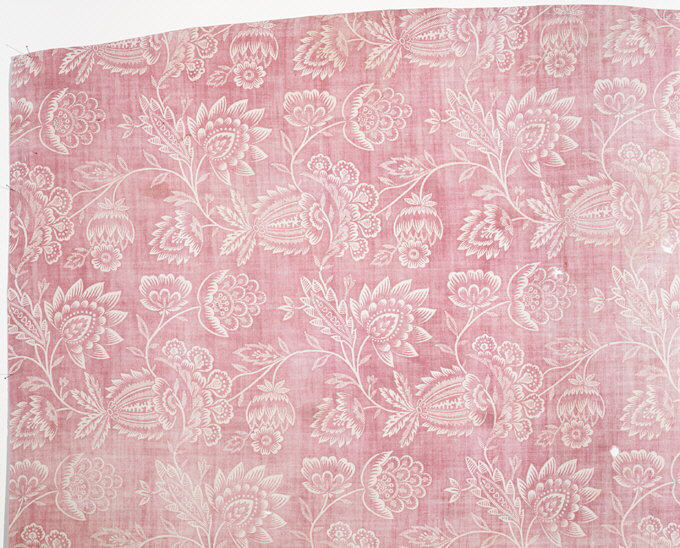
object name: piece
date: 1701-1800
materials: cotton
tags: flowers,leaves